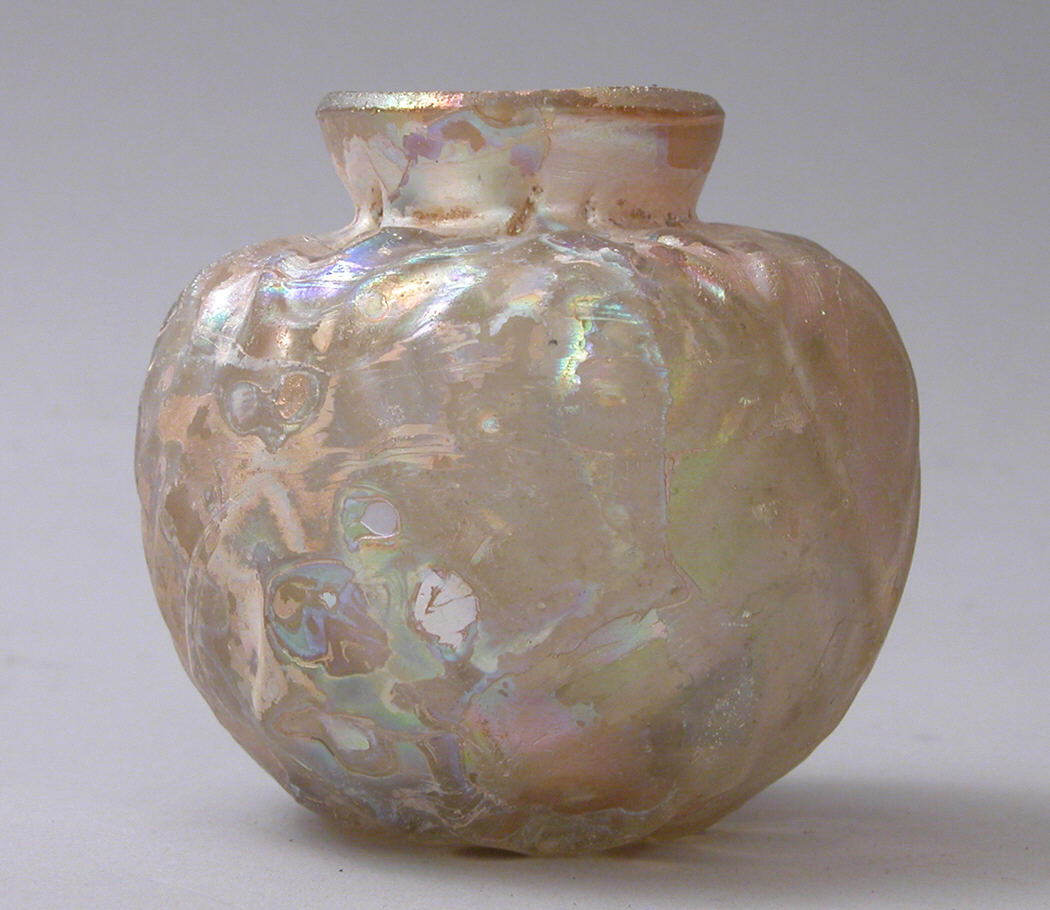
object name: vase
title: Vase with Molded Diamond Pattern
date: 901-1100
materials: glass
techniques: glassblowing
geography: iran